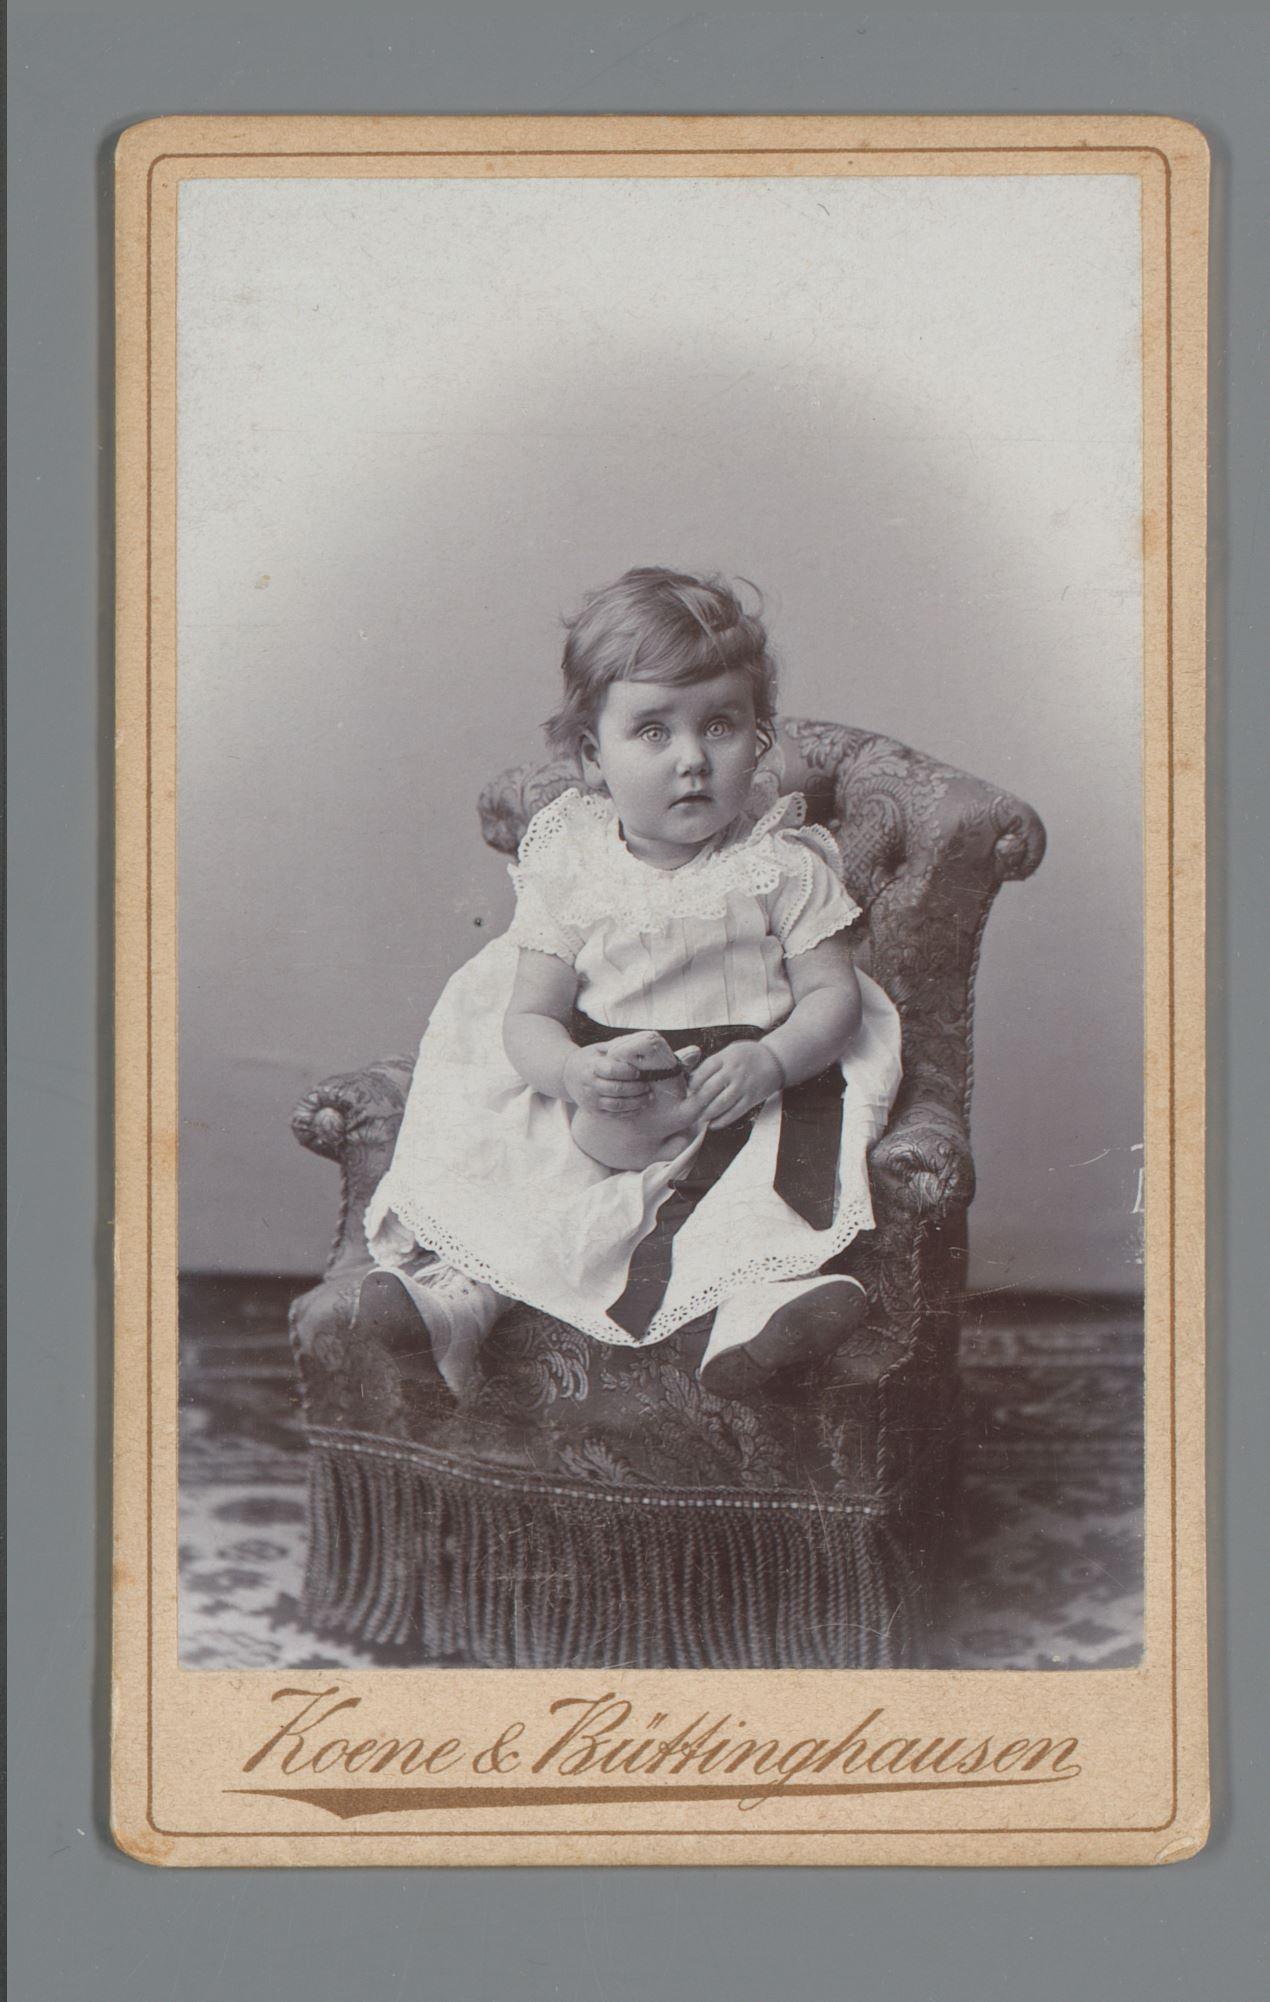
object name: carte de visite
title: Portret van Willem Jonker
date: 1899-1900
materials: cardboard, photographic support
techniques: collodion silver print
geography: amsterdam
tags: historical persons, amsterdam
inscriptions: annotation: ‘Hansje’, workshop stamp: ‘Koene&Büttinghausen/ Amsterdam, Heerengracht 150/ Batavia’